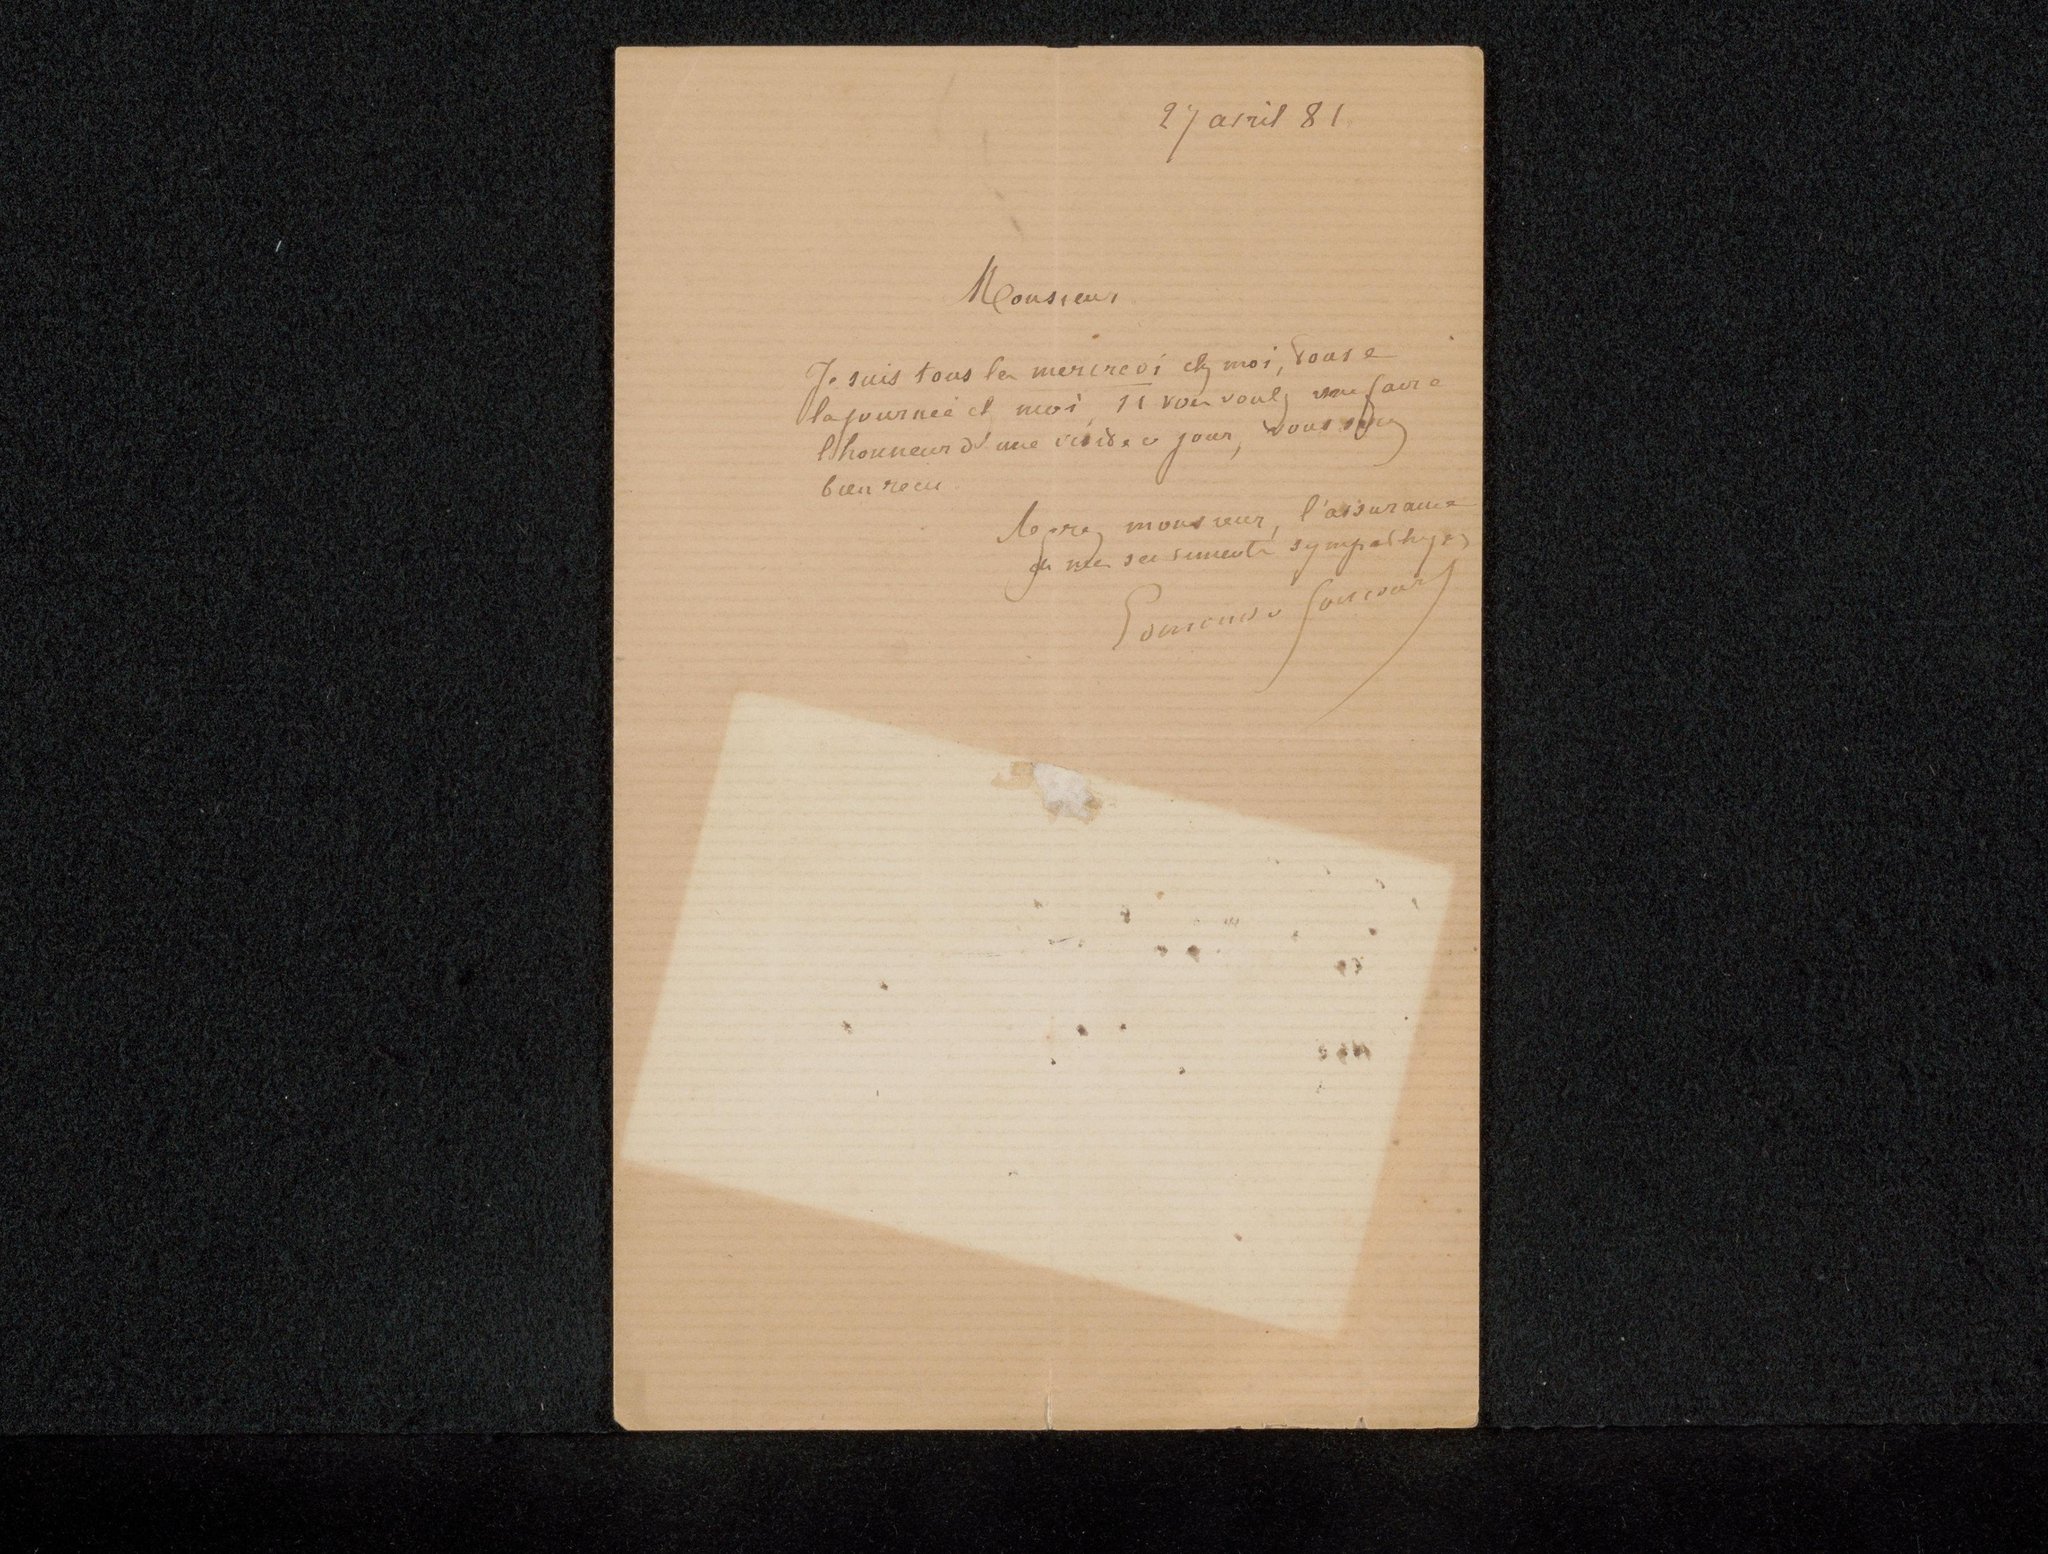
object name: letter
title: Brief aan Philip Zilcken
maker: edmond de goncourt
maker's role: draughtsman, painter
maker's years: 1822-1896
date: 1881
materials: ink, paper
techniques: pen, writing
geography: paris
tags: the hague, philip zilcken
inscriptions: collector's mark: ‘RPK’